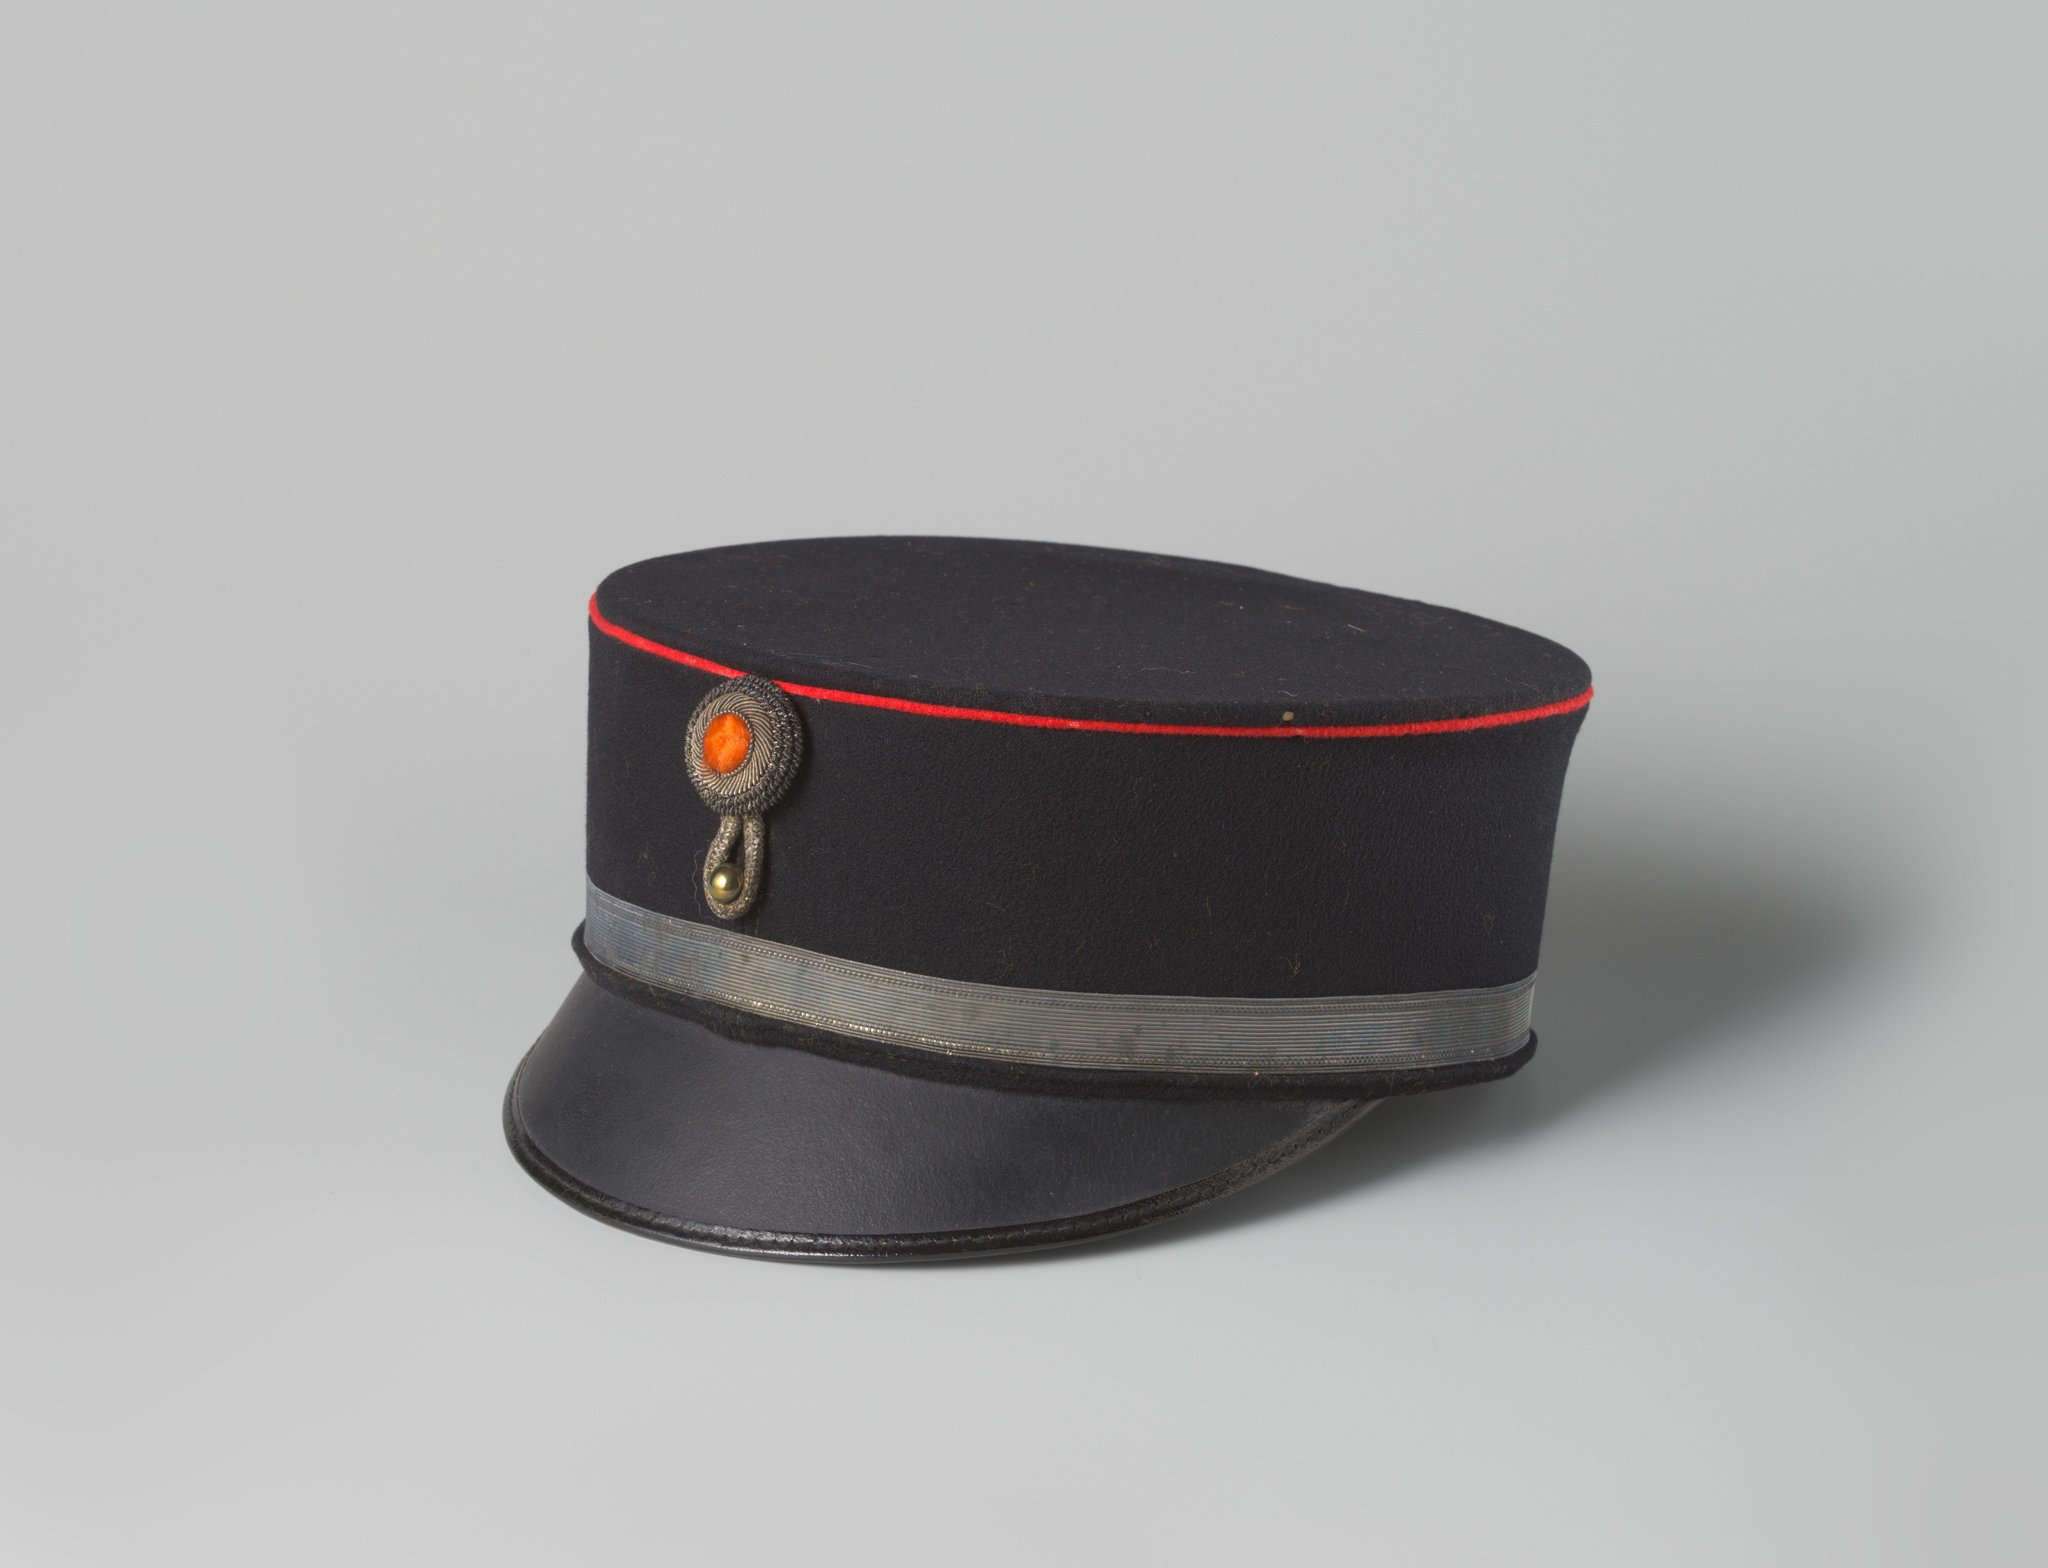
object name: menswear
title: Kepie van zwart laken, versierd met een rode bies, smal zilvergalon en een ronde kokarde met een lis van zilverdraad, onderdeel van een schutterij-uniform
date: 1890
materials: textile, copper, leather, silk, thread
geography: utrecht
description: Kepie van zwart laken, versierd met een rode bies, smal zilvergalon en een ronde kokarde met een lis van zilverdraad, onderdeel van een schutterij-uniform. Adres op de bodem in goud aangebracht: de Erven H. van Dijk/Utrecht, waarboven het Nederlandse wapen met leeuwen en banderol, waarop: Je Maintiendrai.